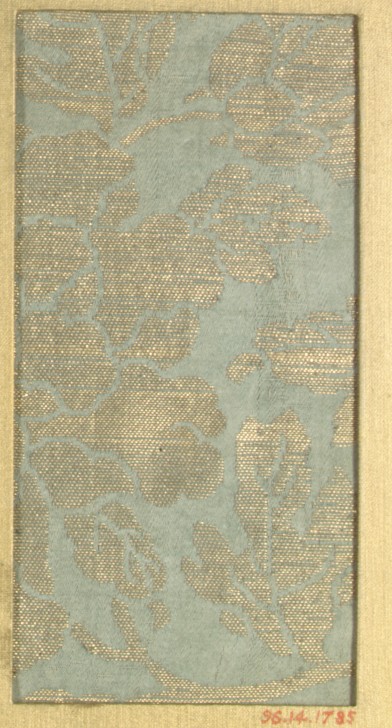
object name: piece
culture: japanese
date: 1701-1900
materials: silk